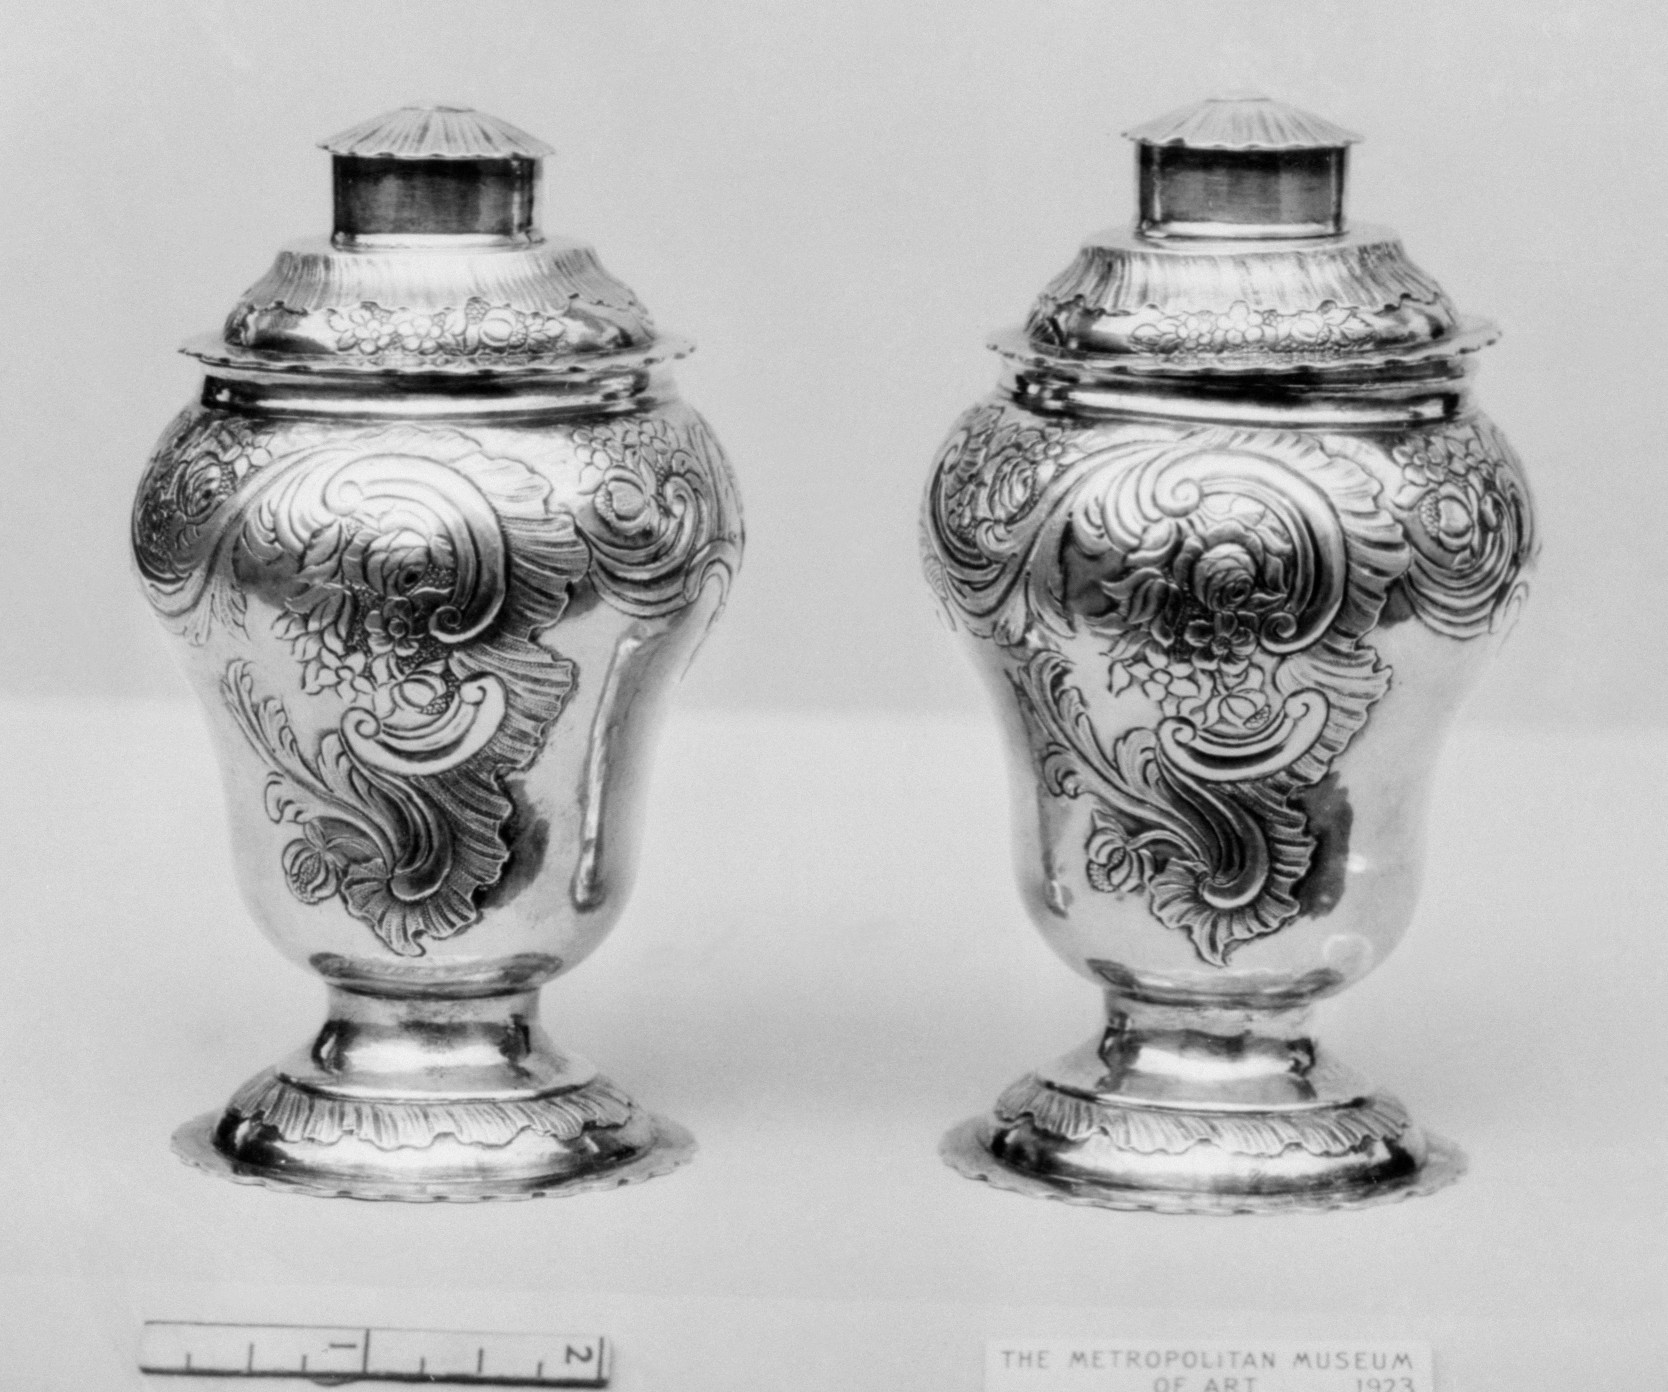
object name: tea caddy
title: Tea caddy (one of a pair)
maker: christopher jonsen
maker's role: maker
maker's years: 1734-1775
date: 1758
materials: silver